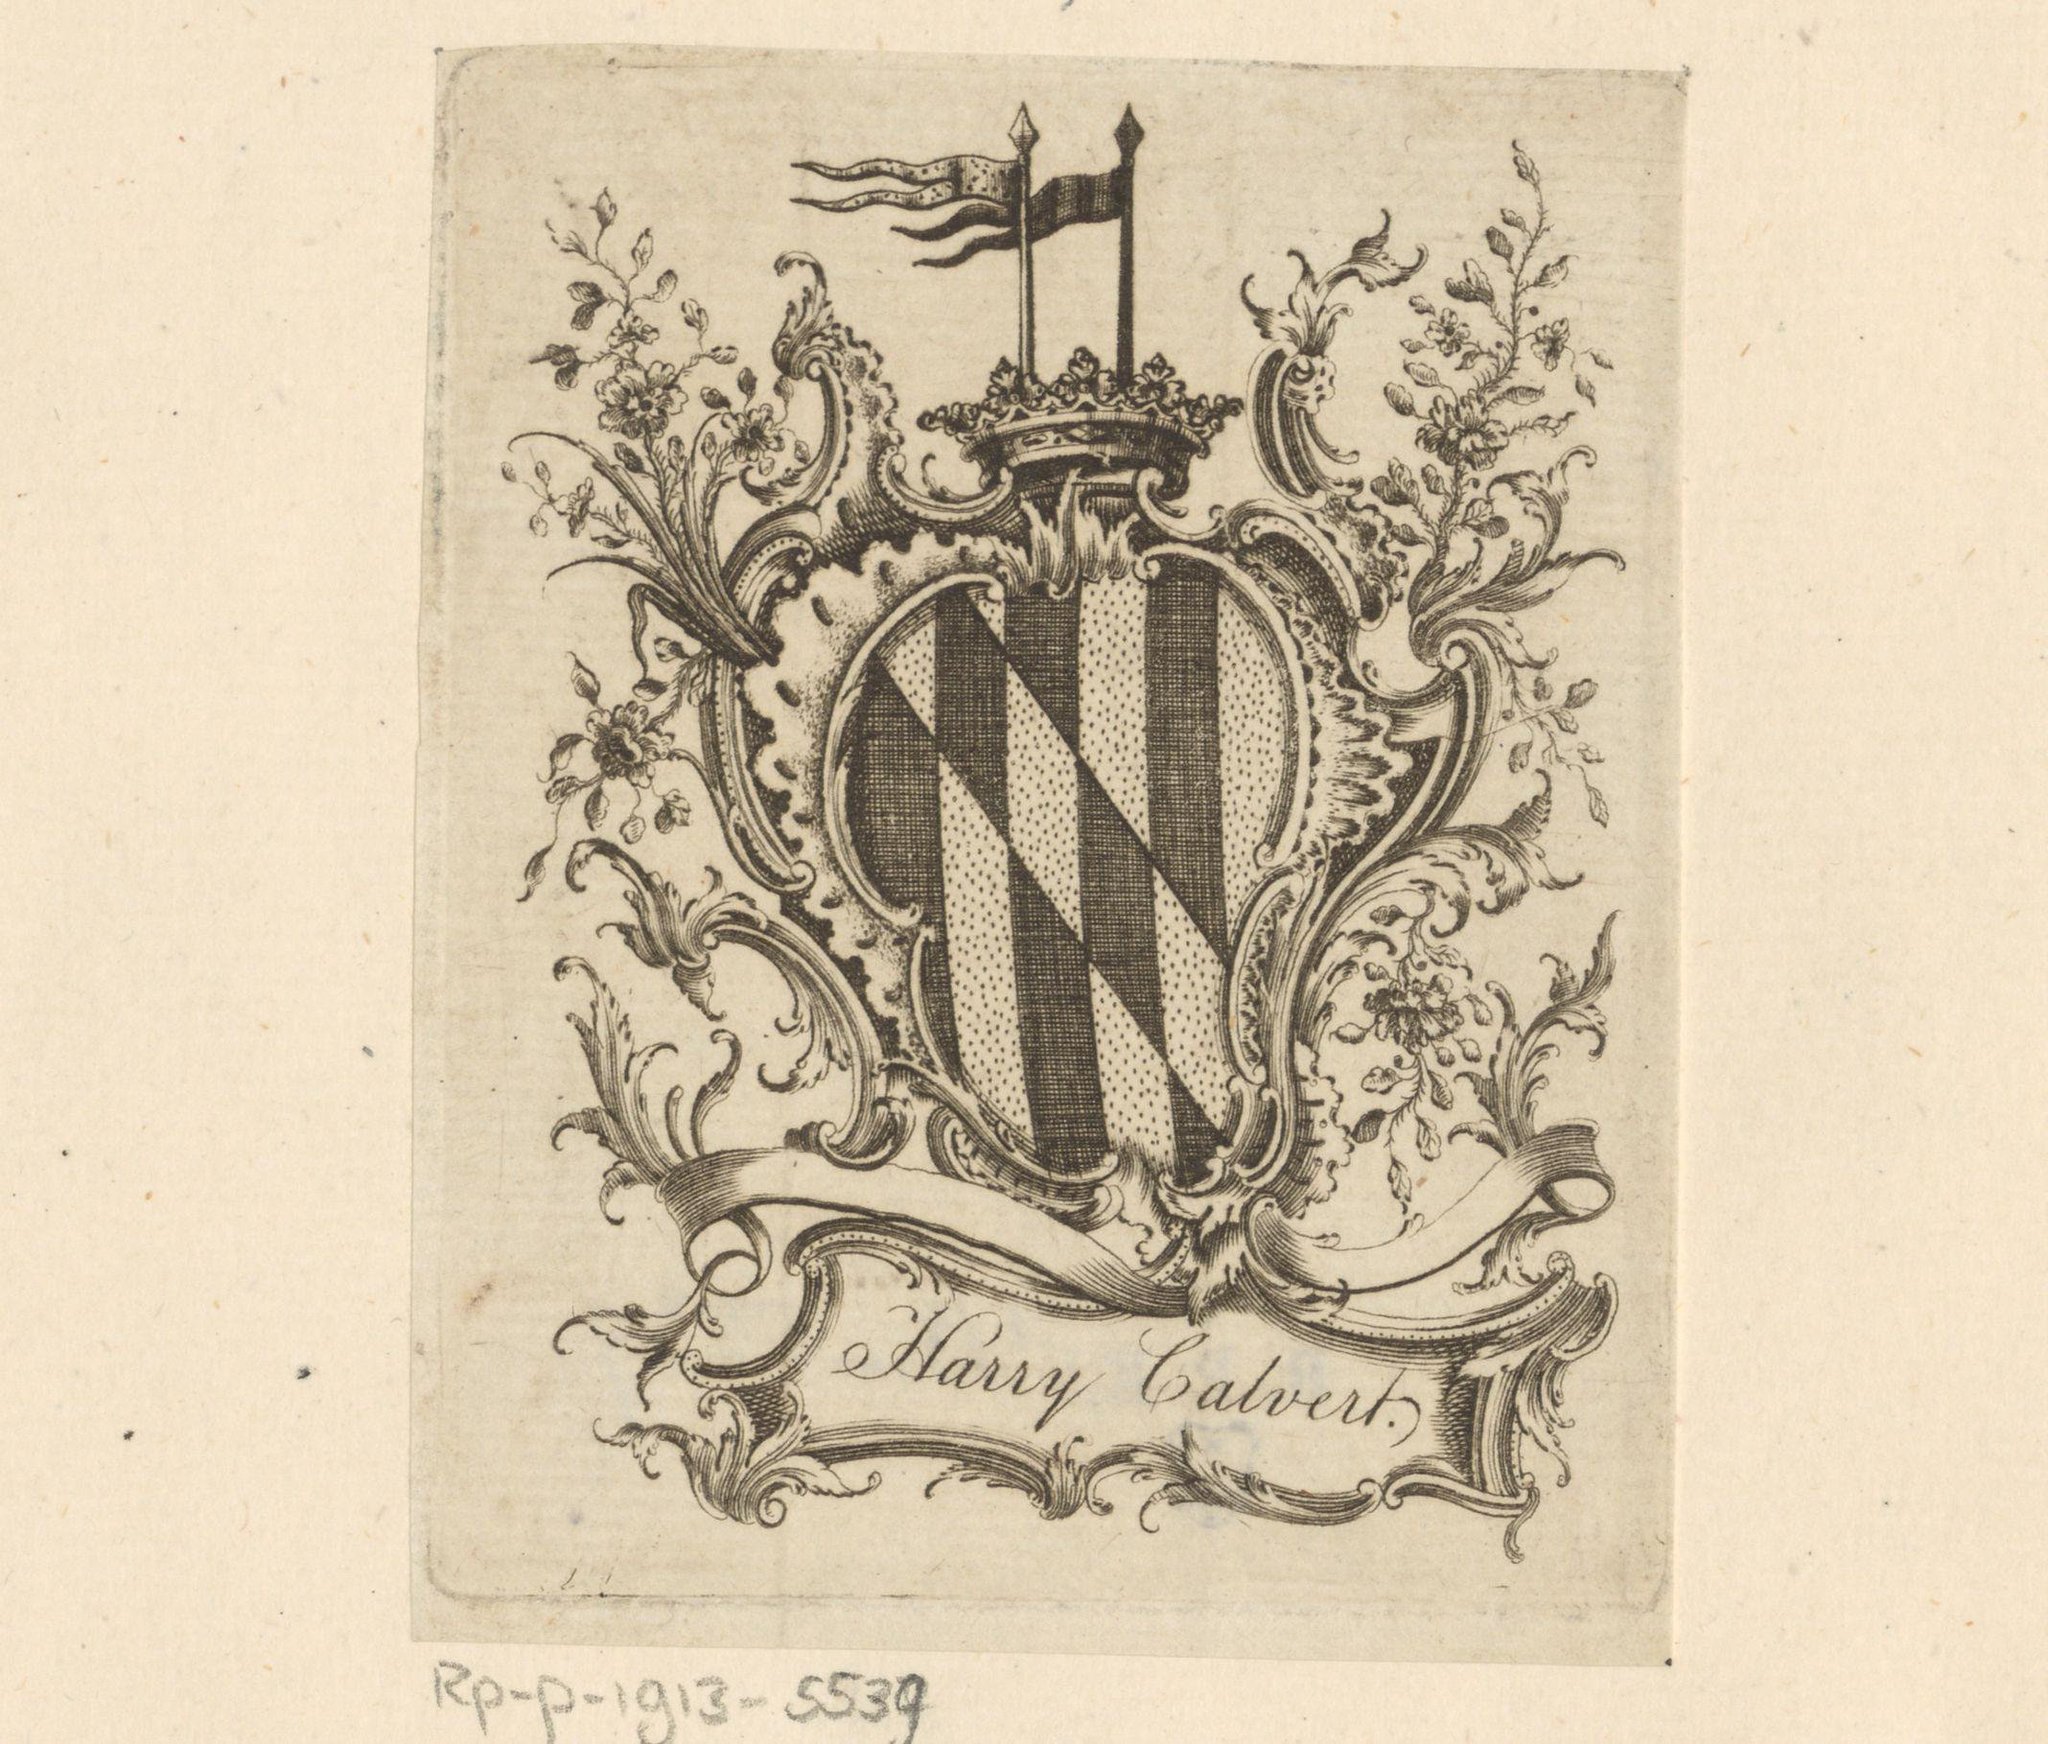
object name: bookplate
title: Ex libris van Harry Calvert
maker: Anonymous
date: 1750-1780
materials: paper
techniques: engraving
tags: armorial bearing, heraldry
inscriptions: collector's mark: Lugt 2233, collector's mark: Lugt 2760